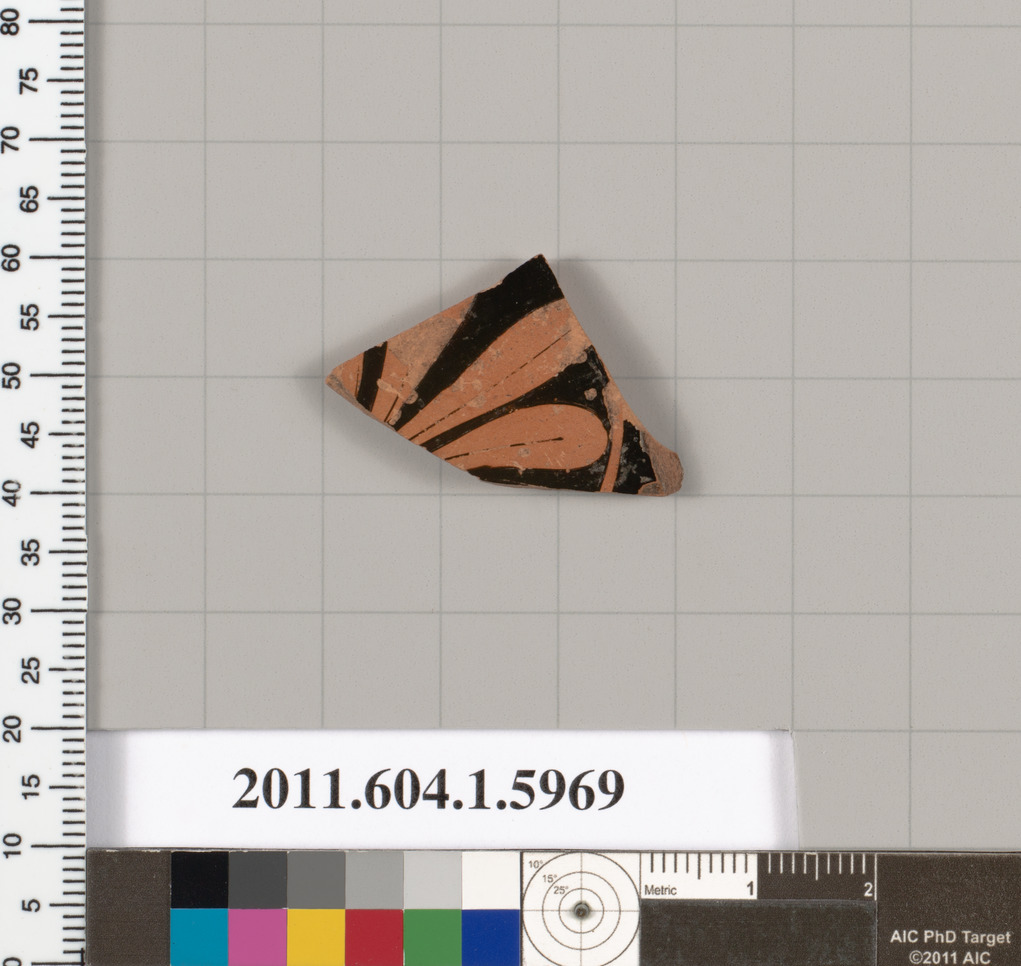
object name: kylix fragment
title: Terracotta fragment of a kylix (drinking cup)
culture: greek, attic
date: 433-567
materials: terracotta